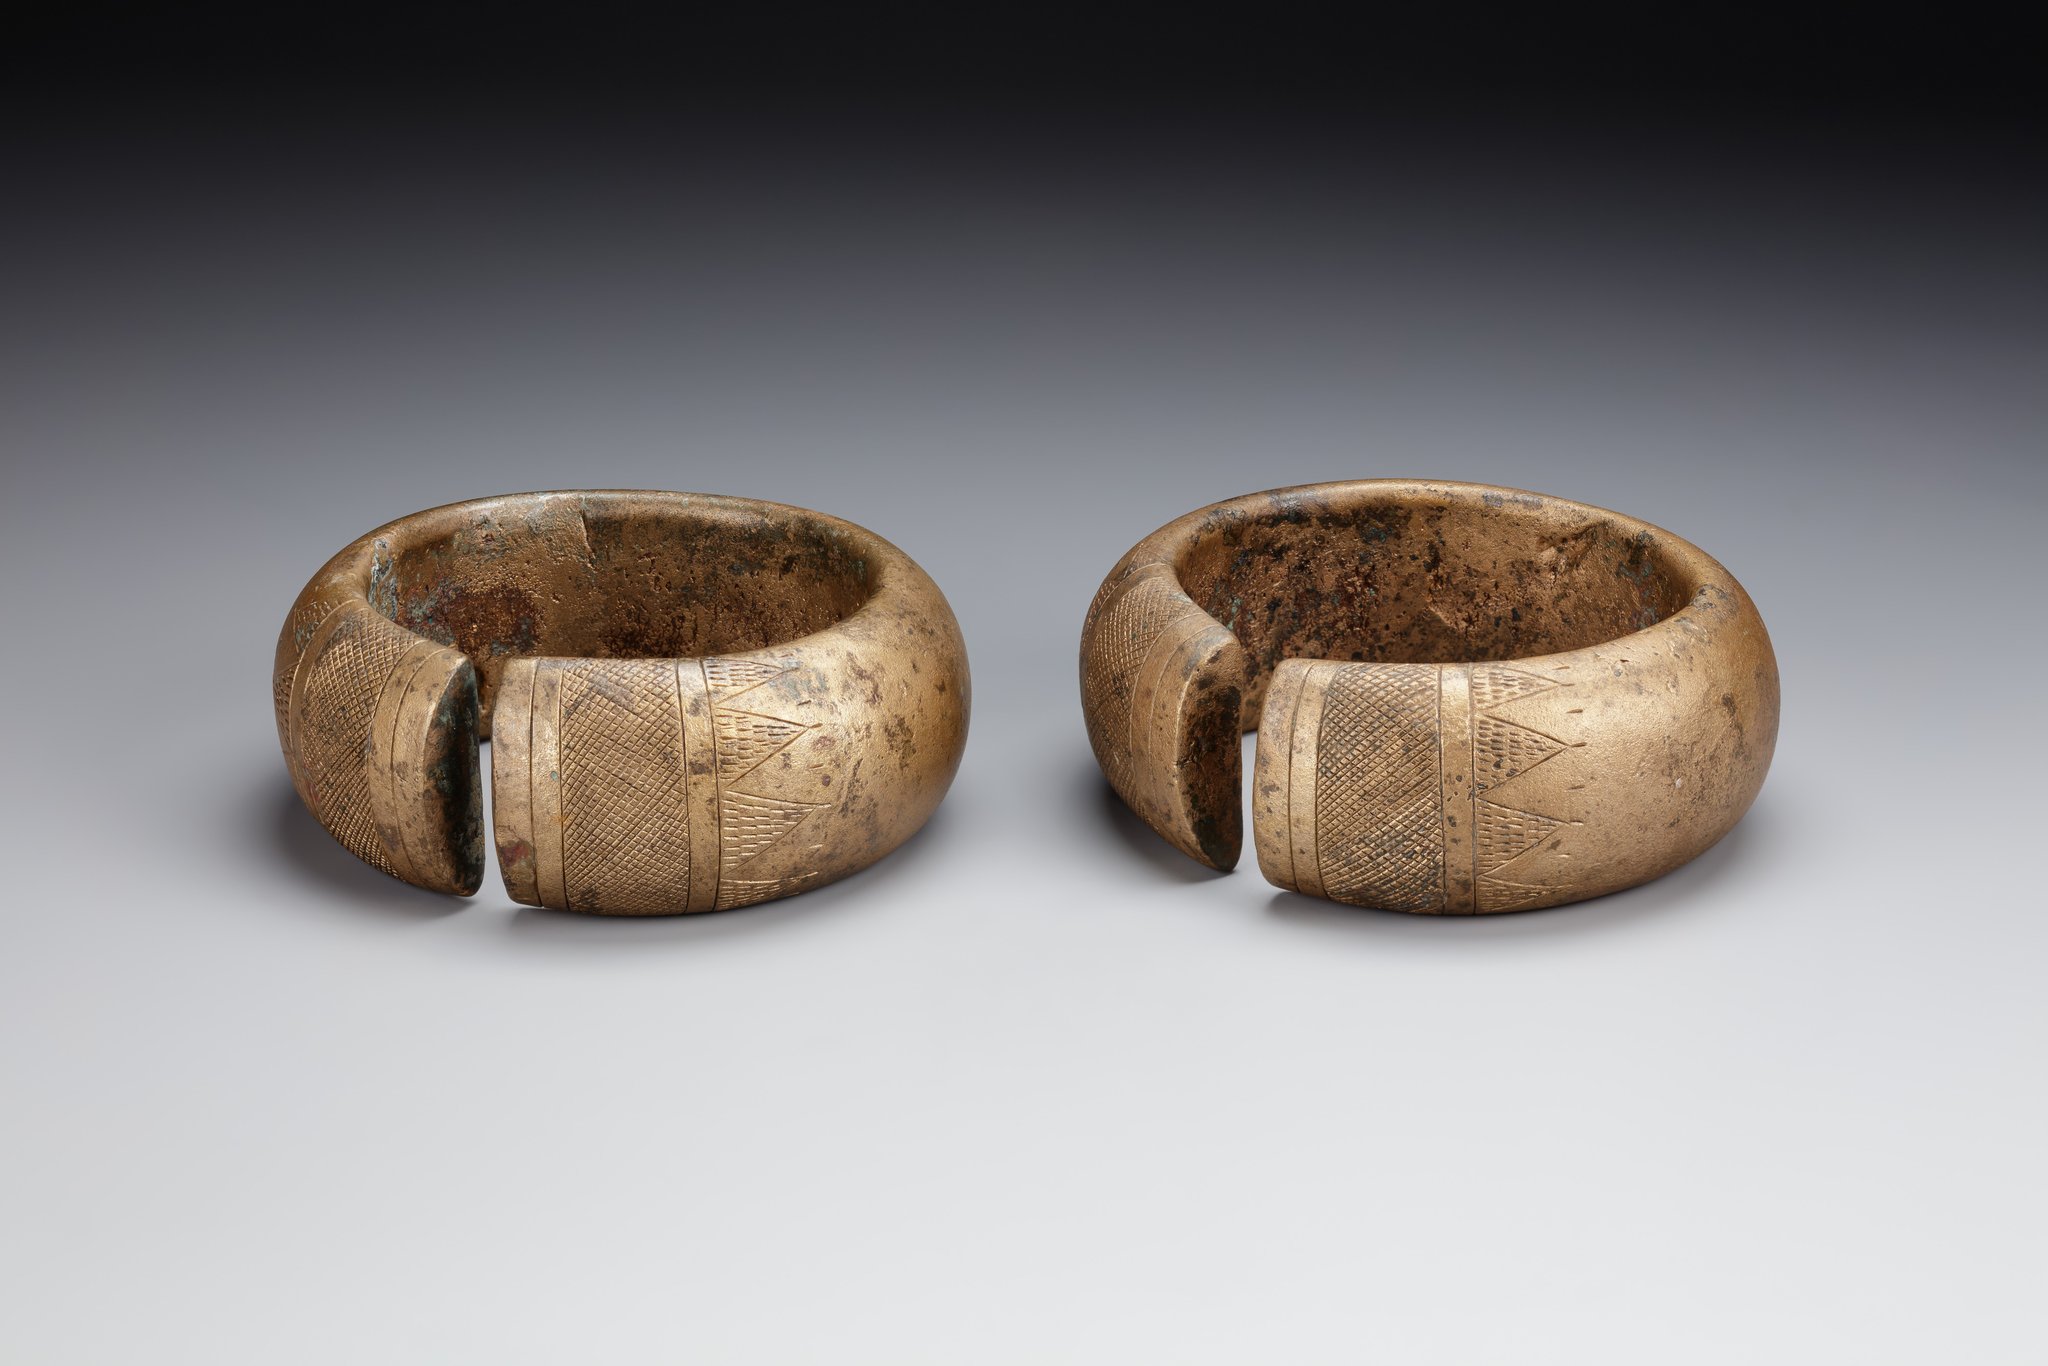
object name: anklet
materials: alloy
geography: nubia